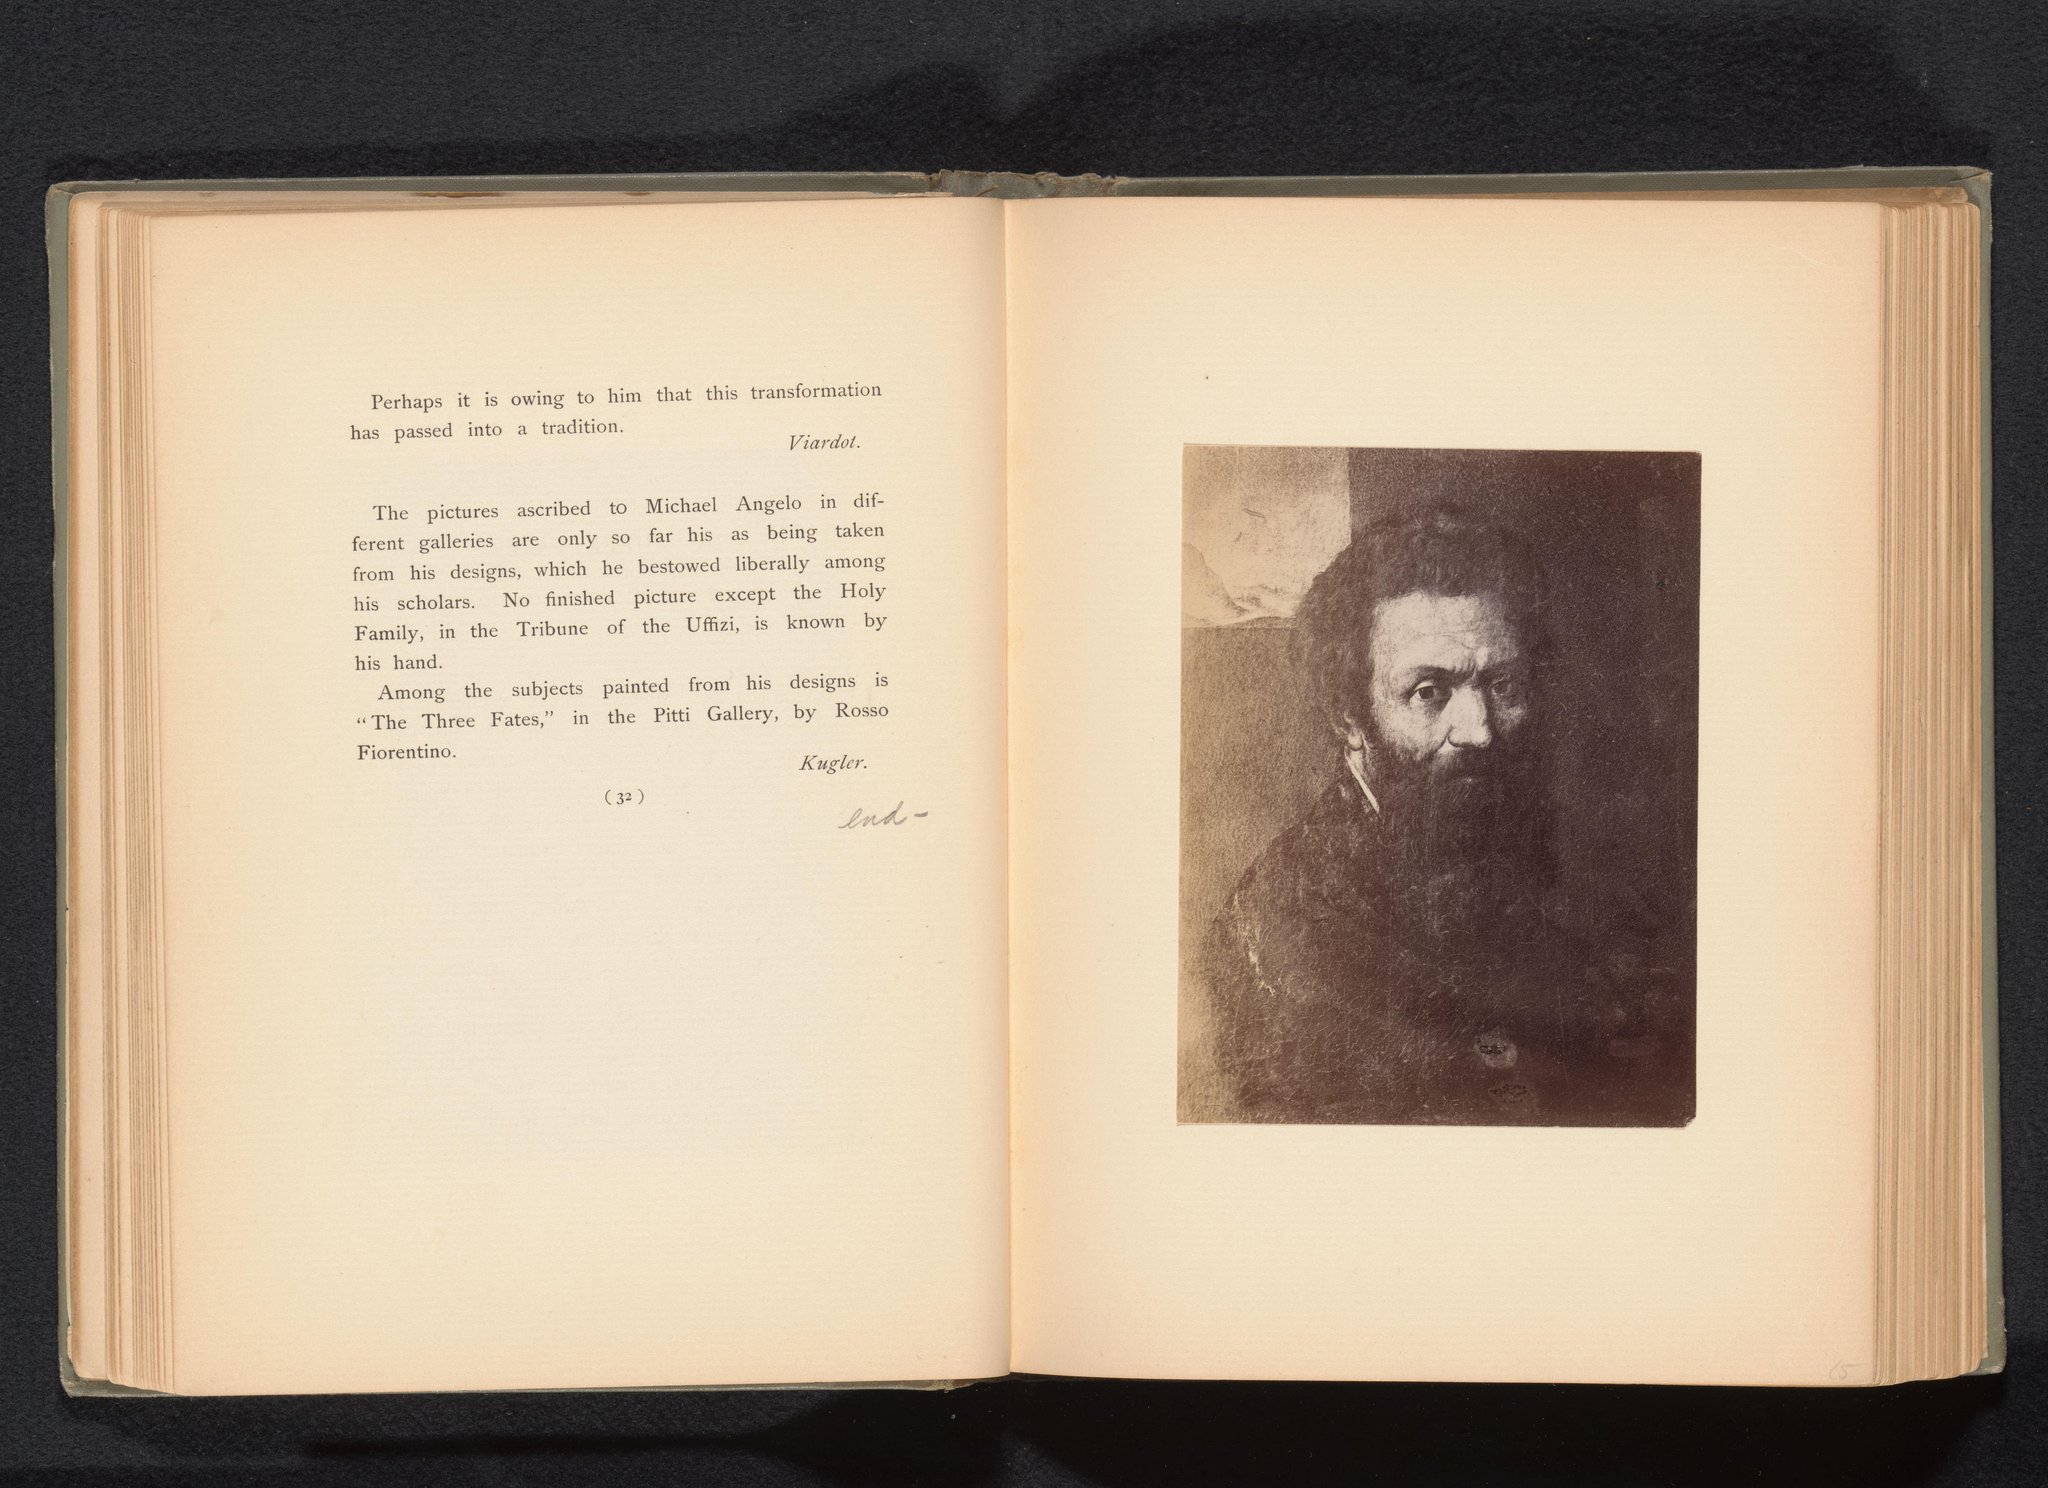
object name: reproduction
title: Fotoreproductie van een schilderij, voorstellende een portret van Michelangelo Buonarroti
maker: Anonymous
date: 1882-1887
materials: photographic support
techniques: albumen print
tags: rome, painter, draughtsman, sculptor, michelangelo, portrait, self-portrait of artist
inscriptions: number: ‘593’